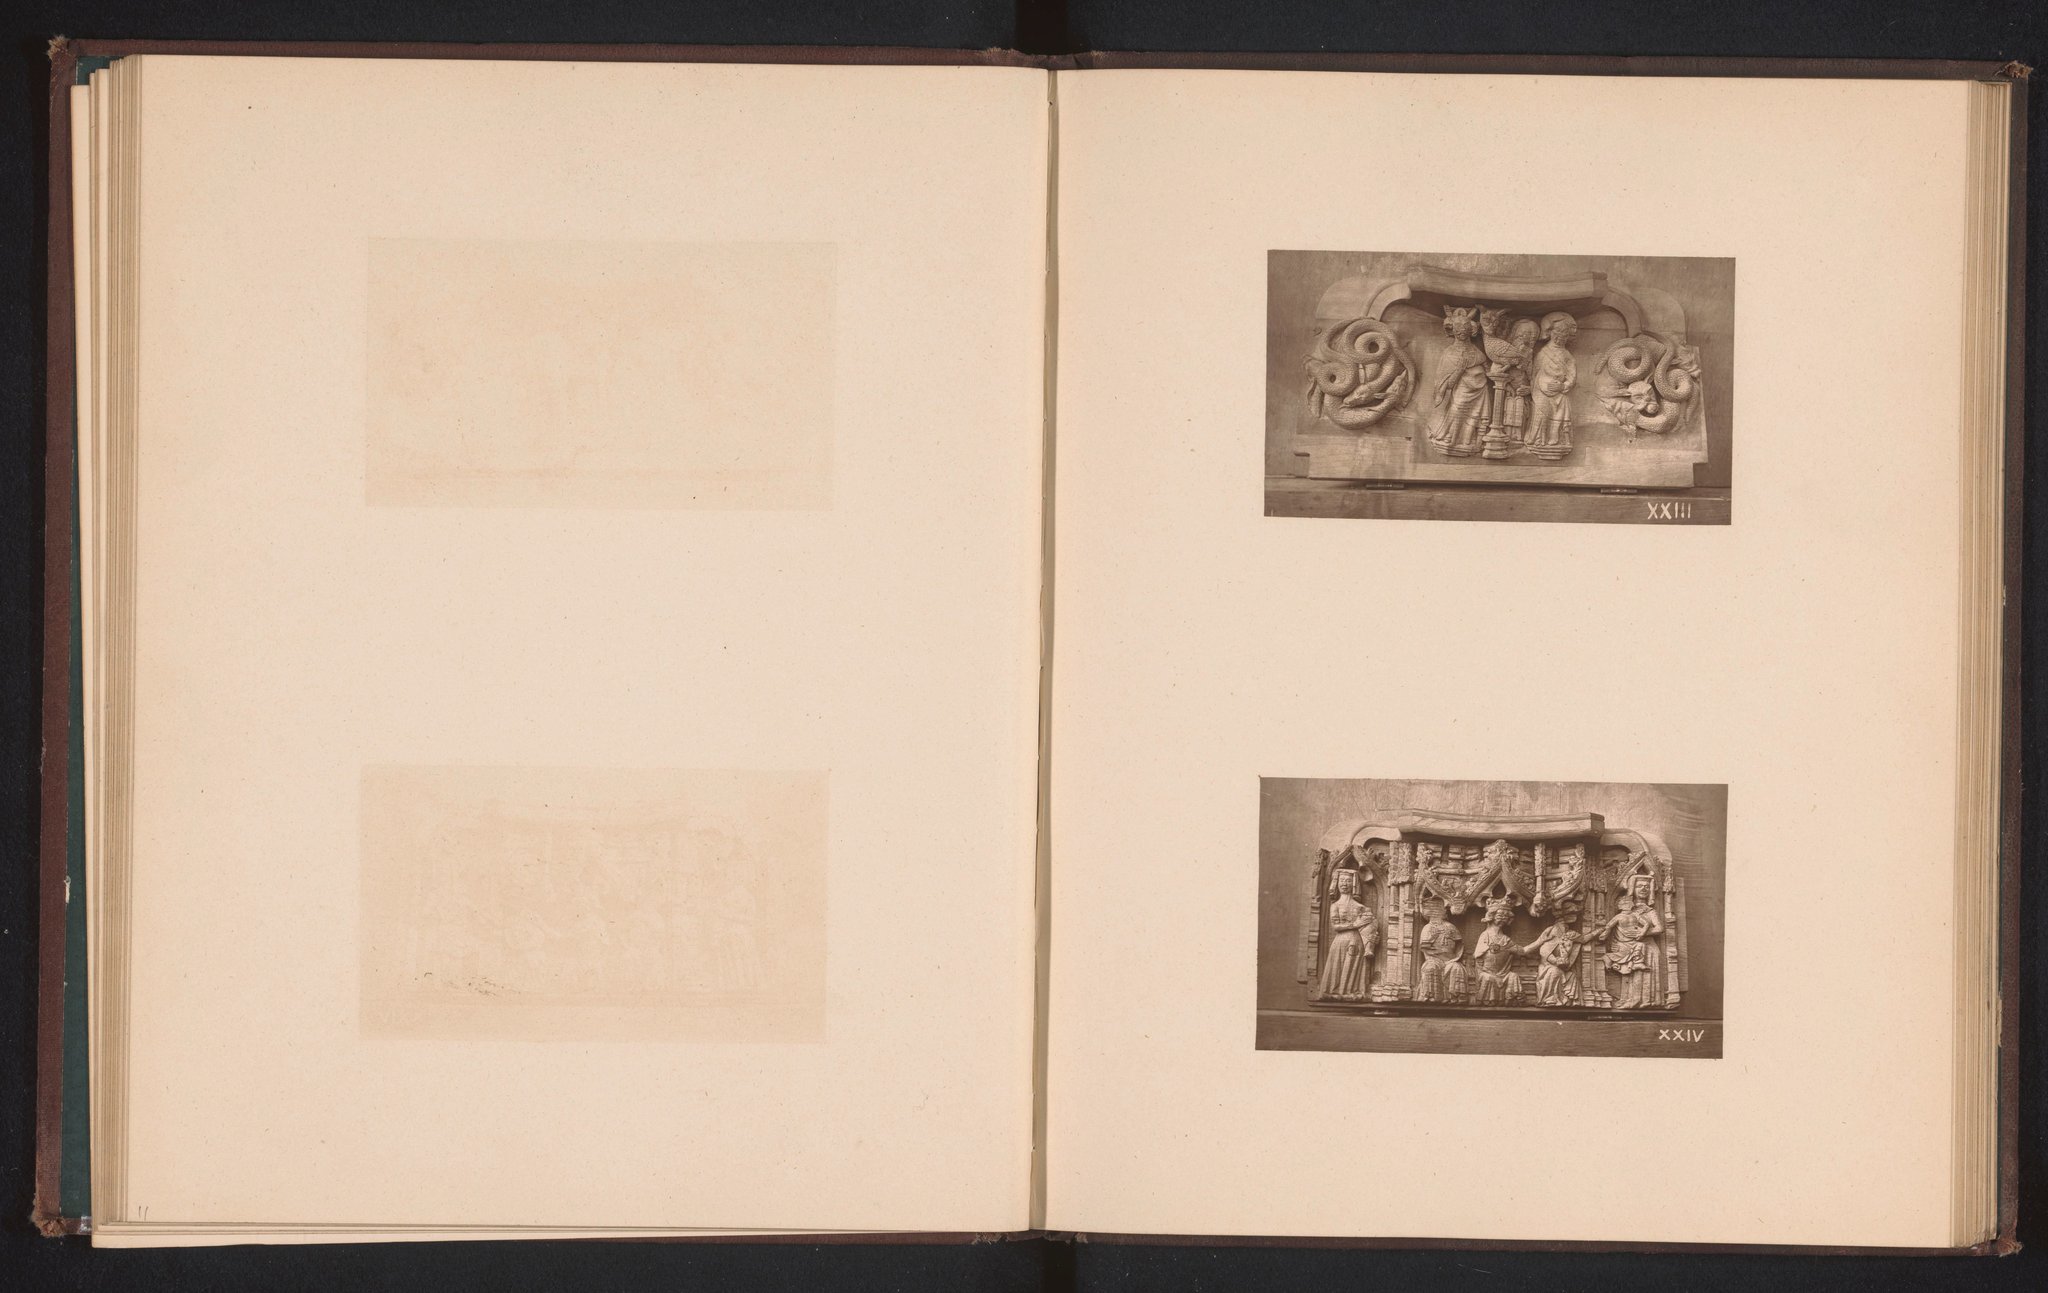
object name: page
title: Twee houtsnijwerken in de Kathedraal van Worcester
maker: Anonymous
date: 1863-1873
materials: paper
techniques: woodburytype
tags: carving ~ applied arts, adoration of the kings: the wise men present their gifts to the christ-child (gold, frankincense and myrrh), interior of church, anyone who is bitten by a snake is cured by looking at the brazen serpent; the serpent (or dragon) is usually depicted on a tau-shaped cross or on a pillar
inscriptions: number: ‘XXIII (...) XXIV’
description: Boven Mozes met de bronzen slang tussen twee fantasiewezens, onder de aanbidding der koningen.